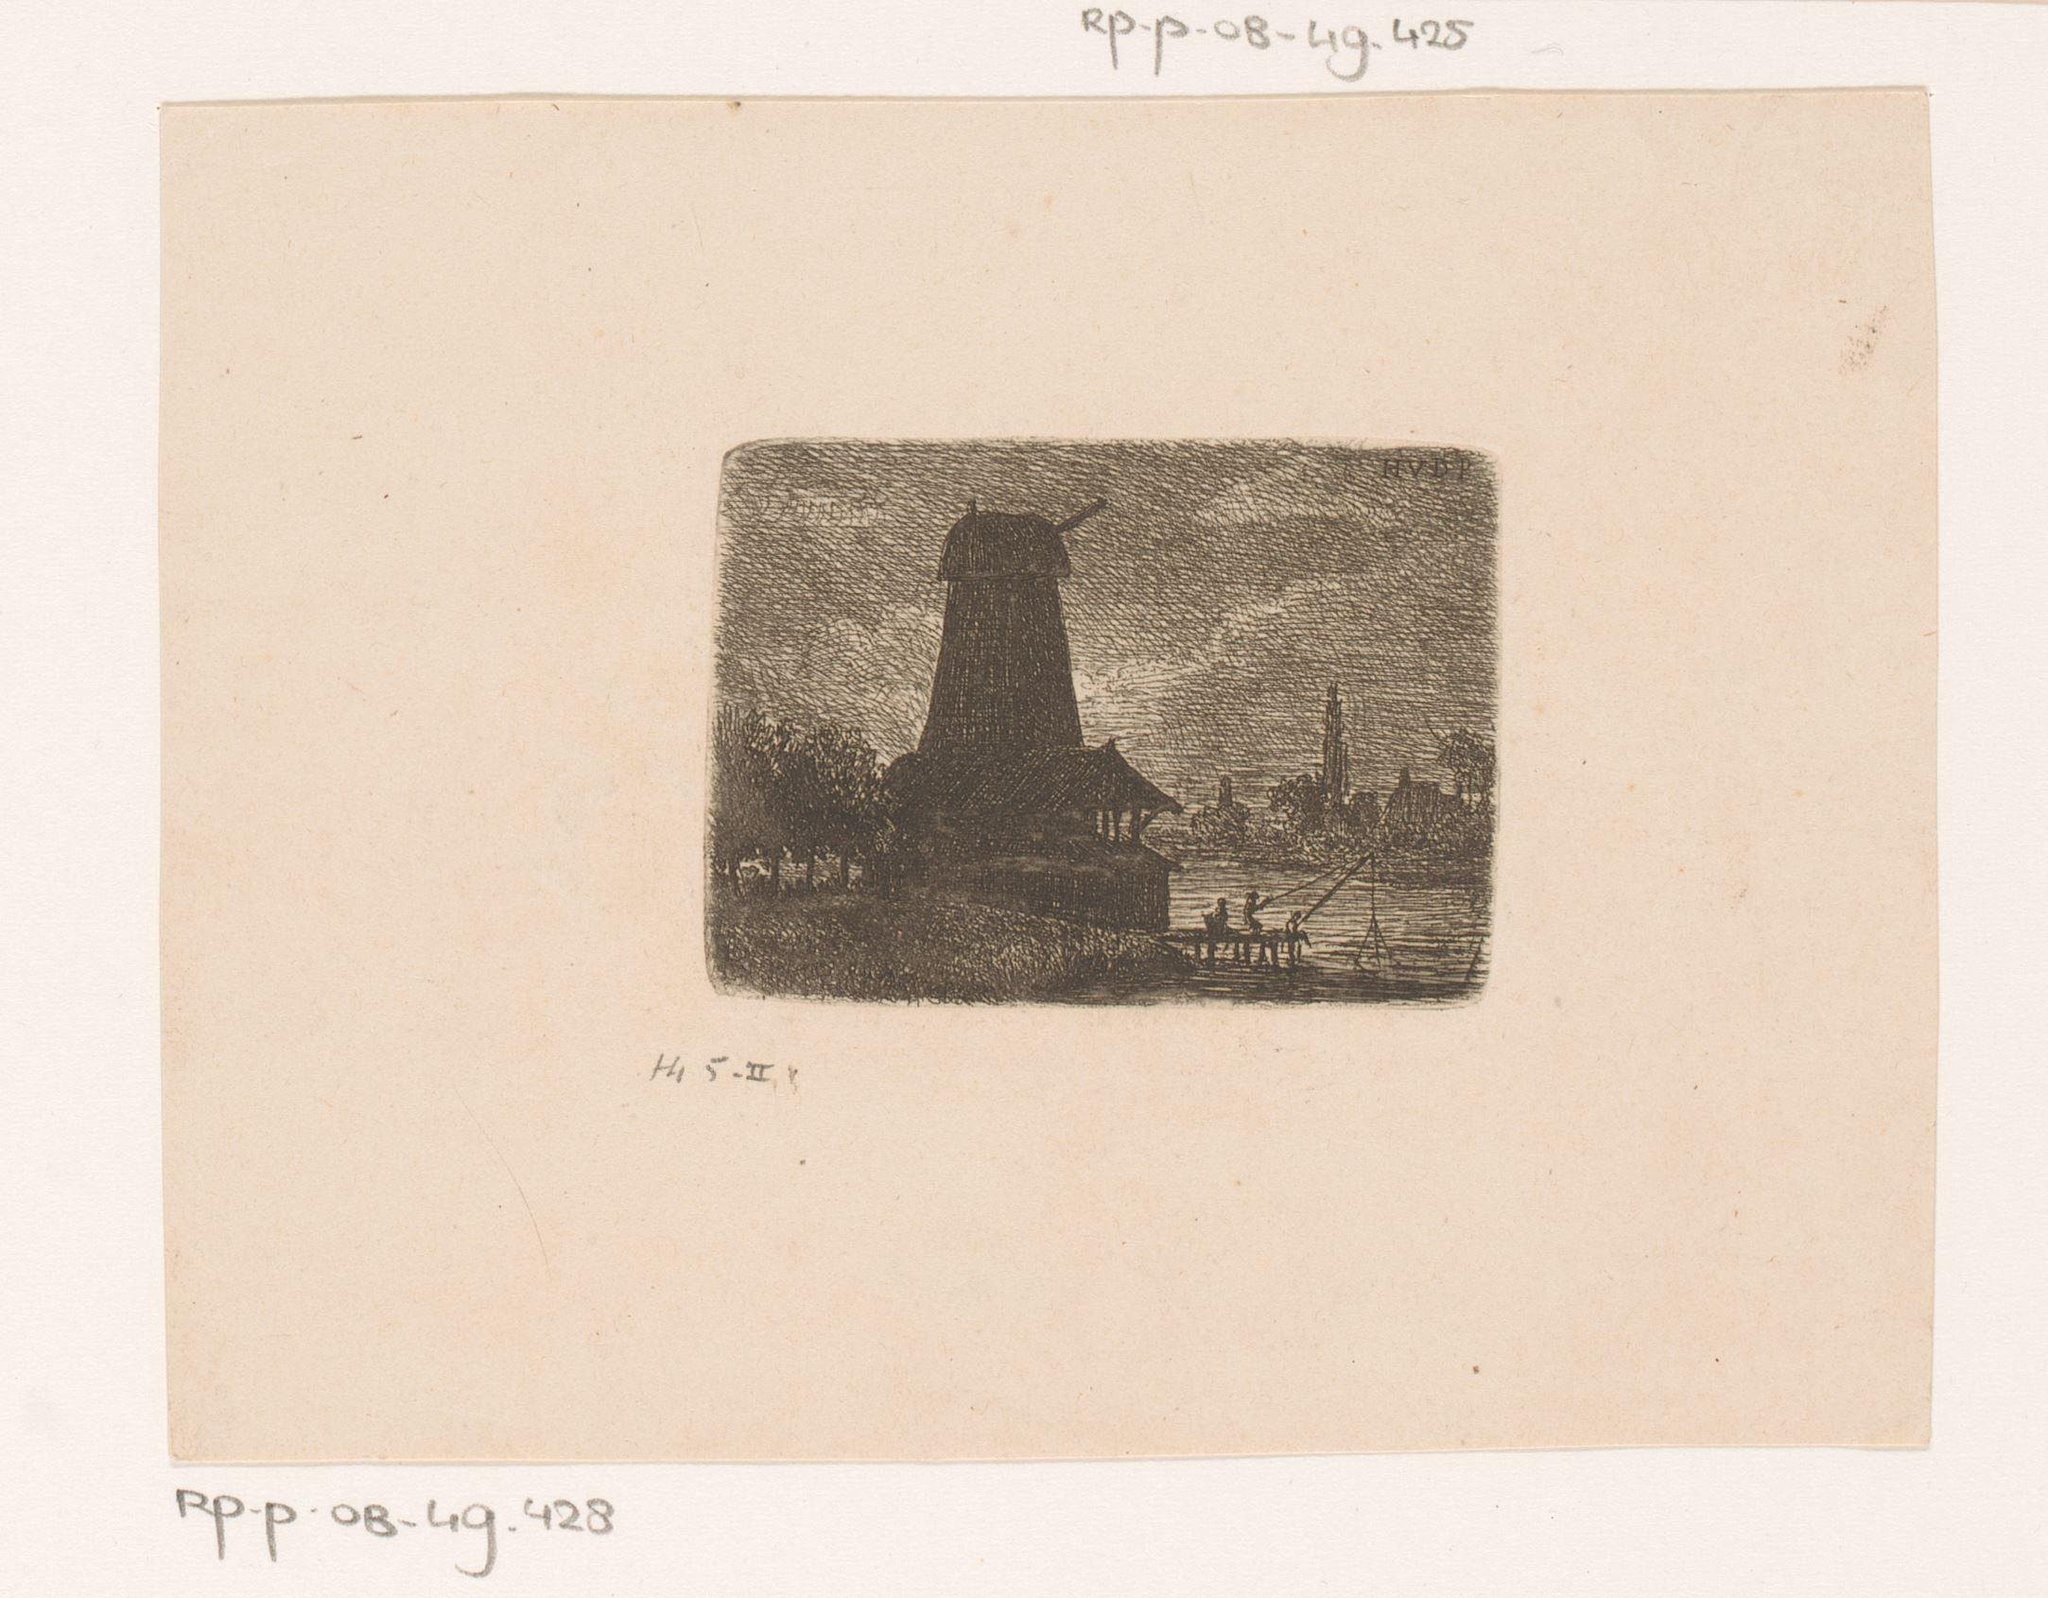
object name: print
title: Poldermolen bij Antwerpen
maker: hendrik jozef franciscus van der poorten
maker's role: draughtsman, print maker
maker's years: 1789-1874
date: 1841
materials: paper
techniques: etching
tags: windmill in landscape, angling, antwerp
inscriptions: collector's mark: Lugt 2228